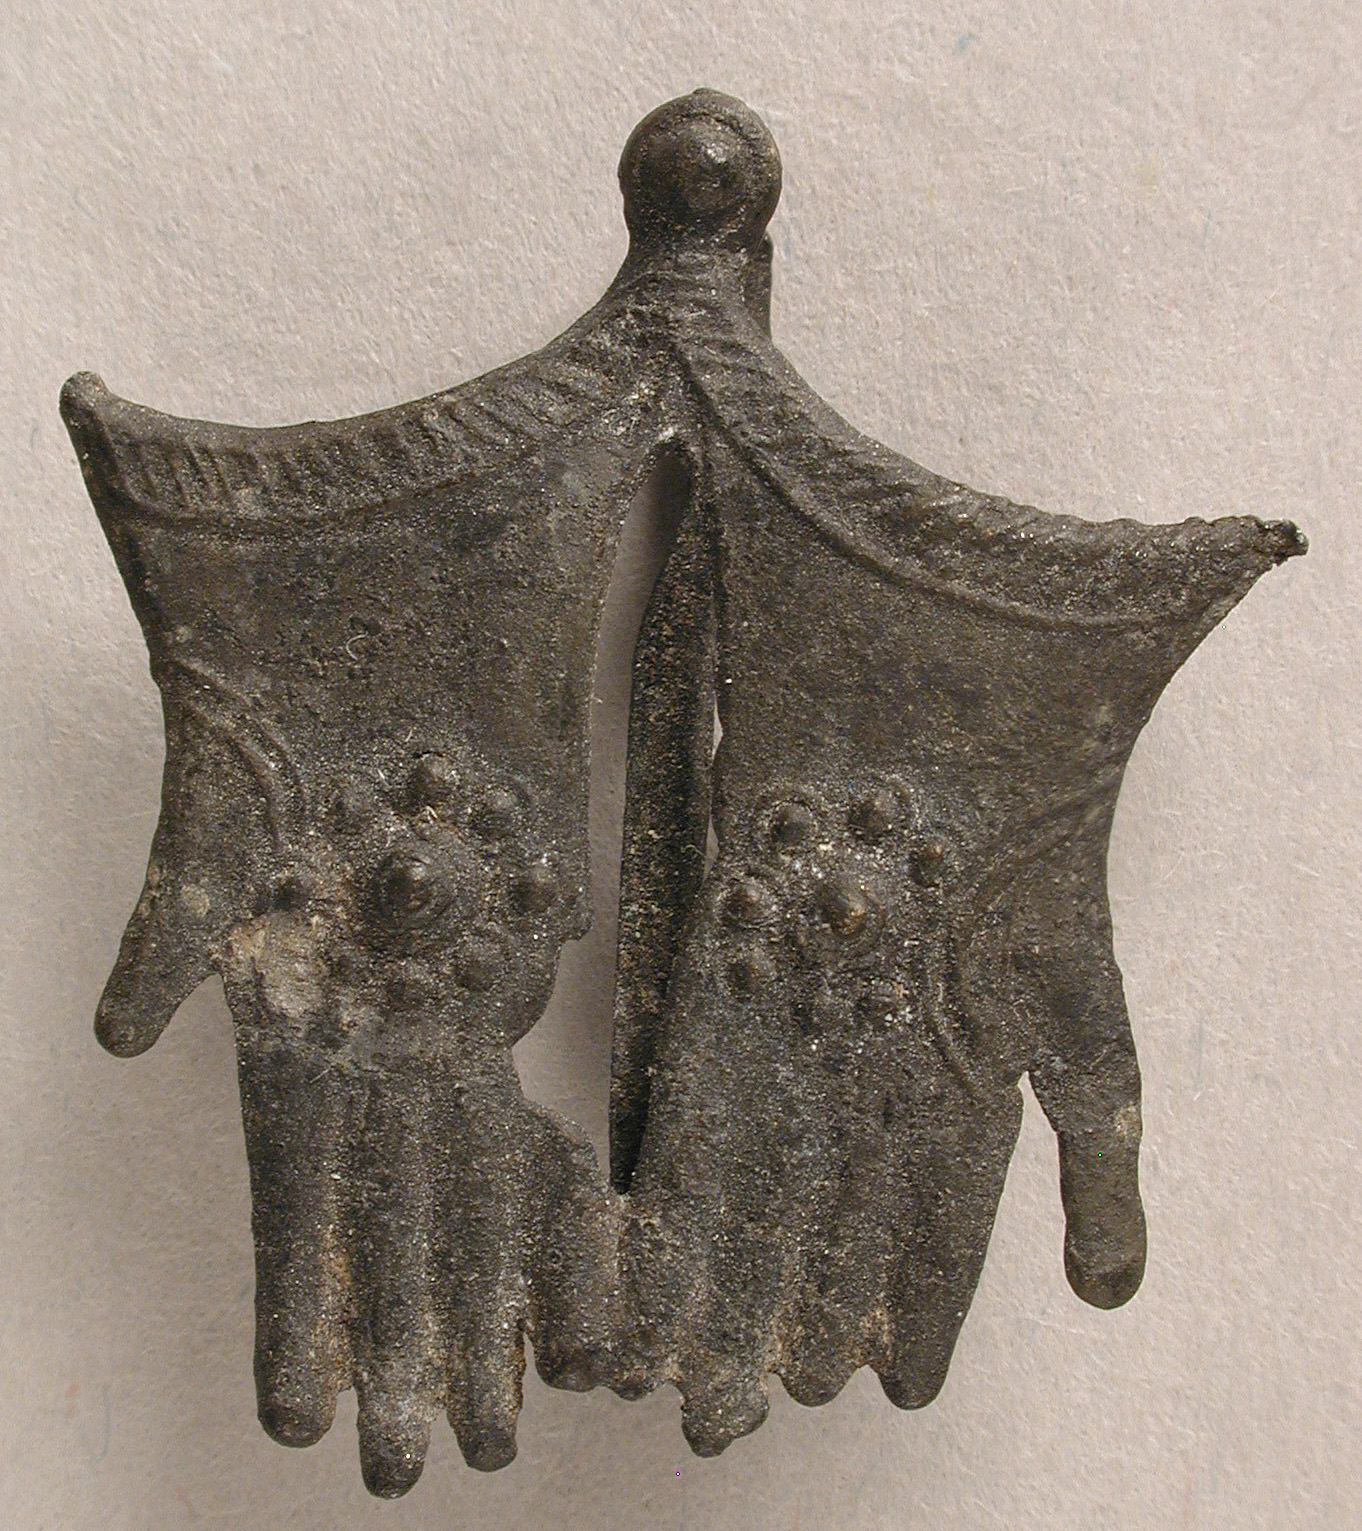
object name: pilgrim's badge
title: Pilgrim's Badge with Becket's Gloves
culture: british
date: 1401-1500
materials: pewter, tin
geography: england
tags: gloves